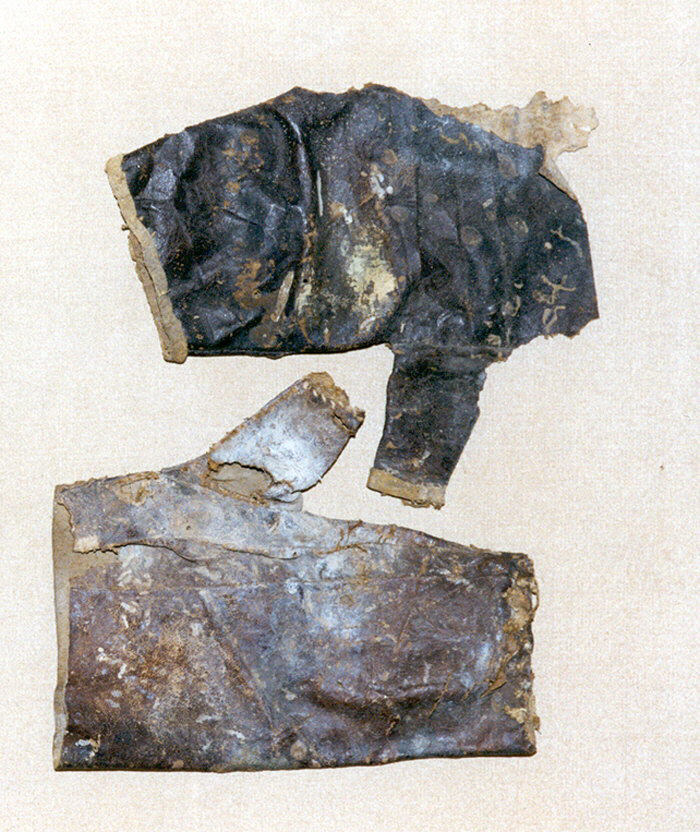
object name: textile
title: Fingerless leather gloves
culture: alanic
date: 601-900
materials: leather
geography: caucasus